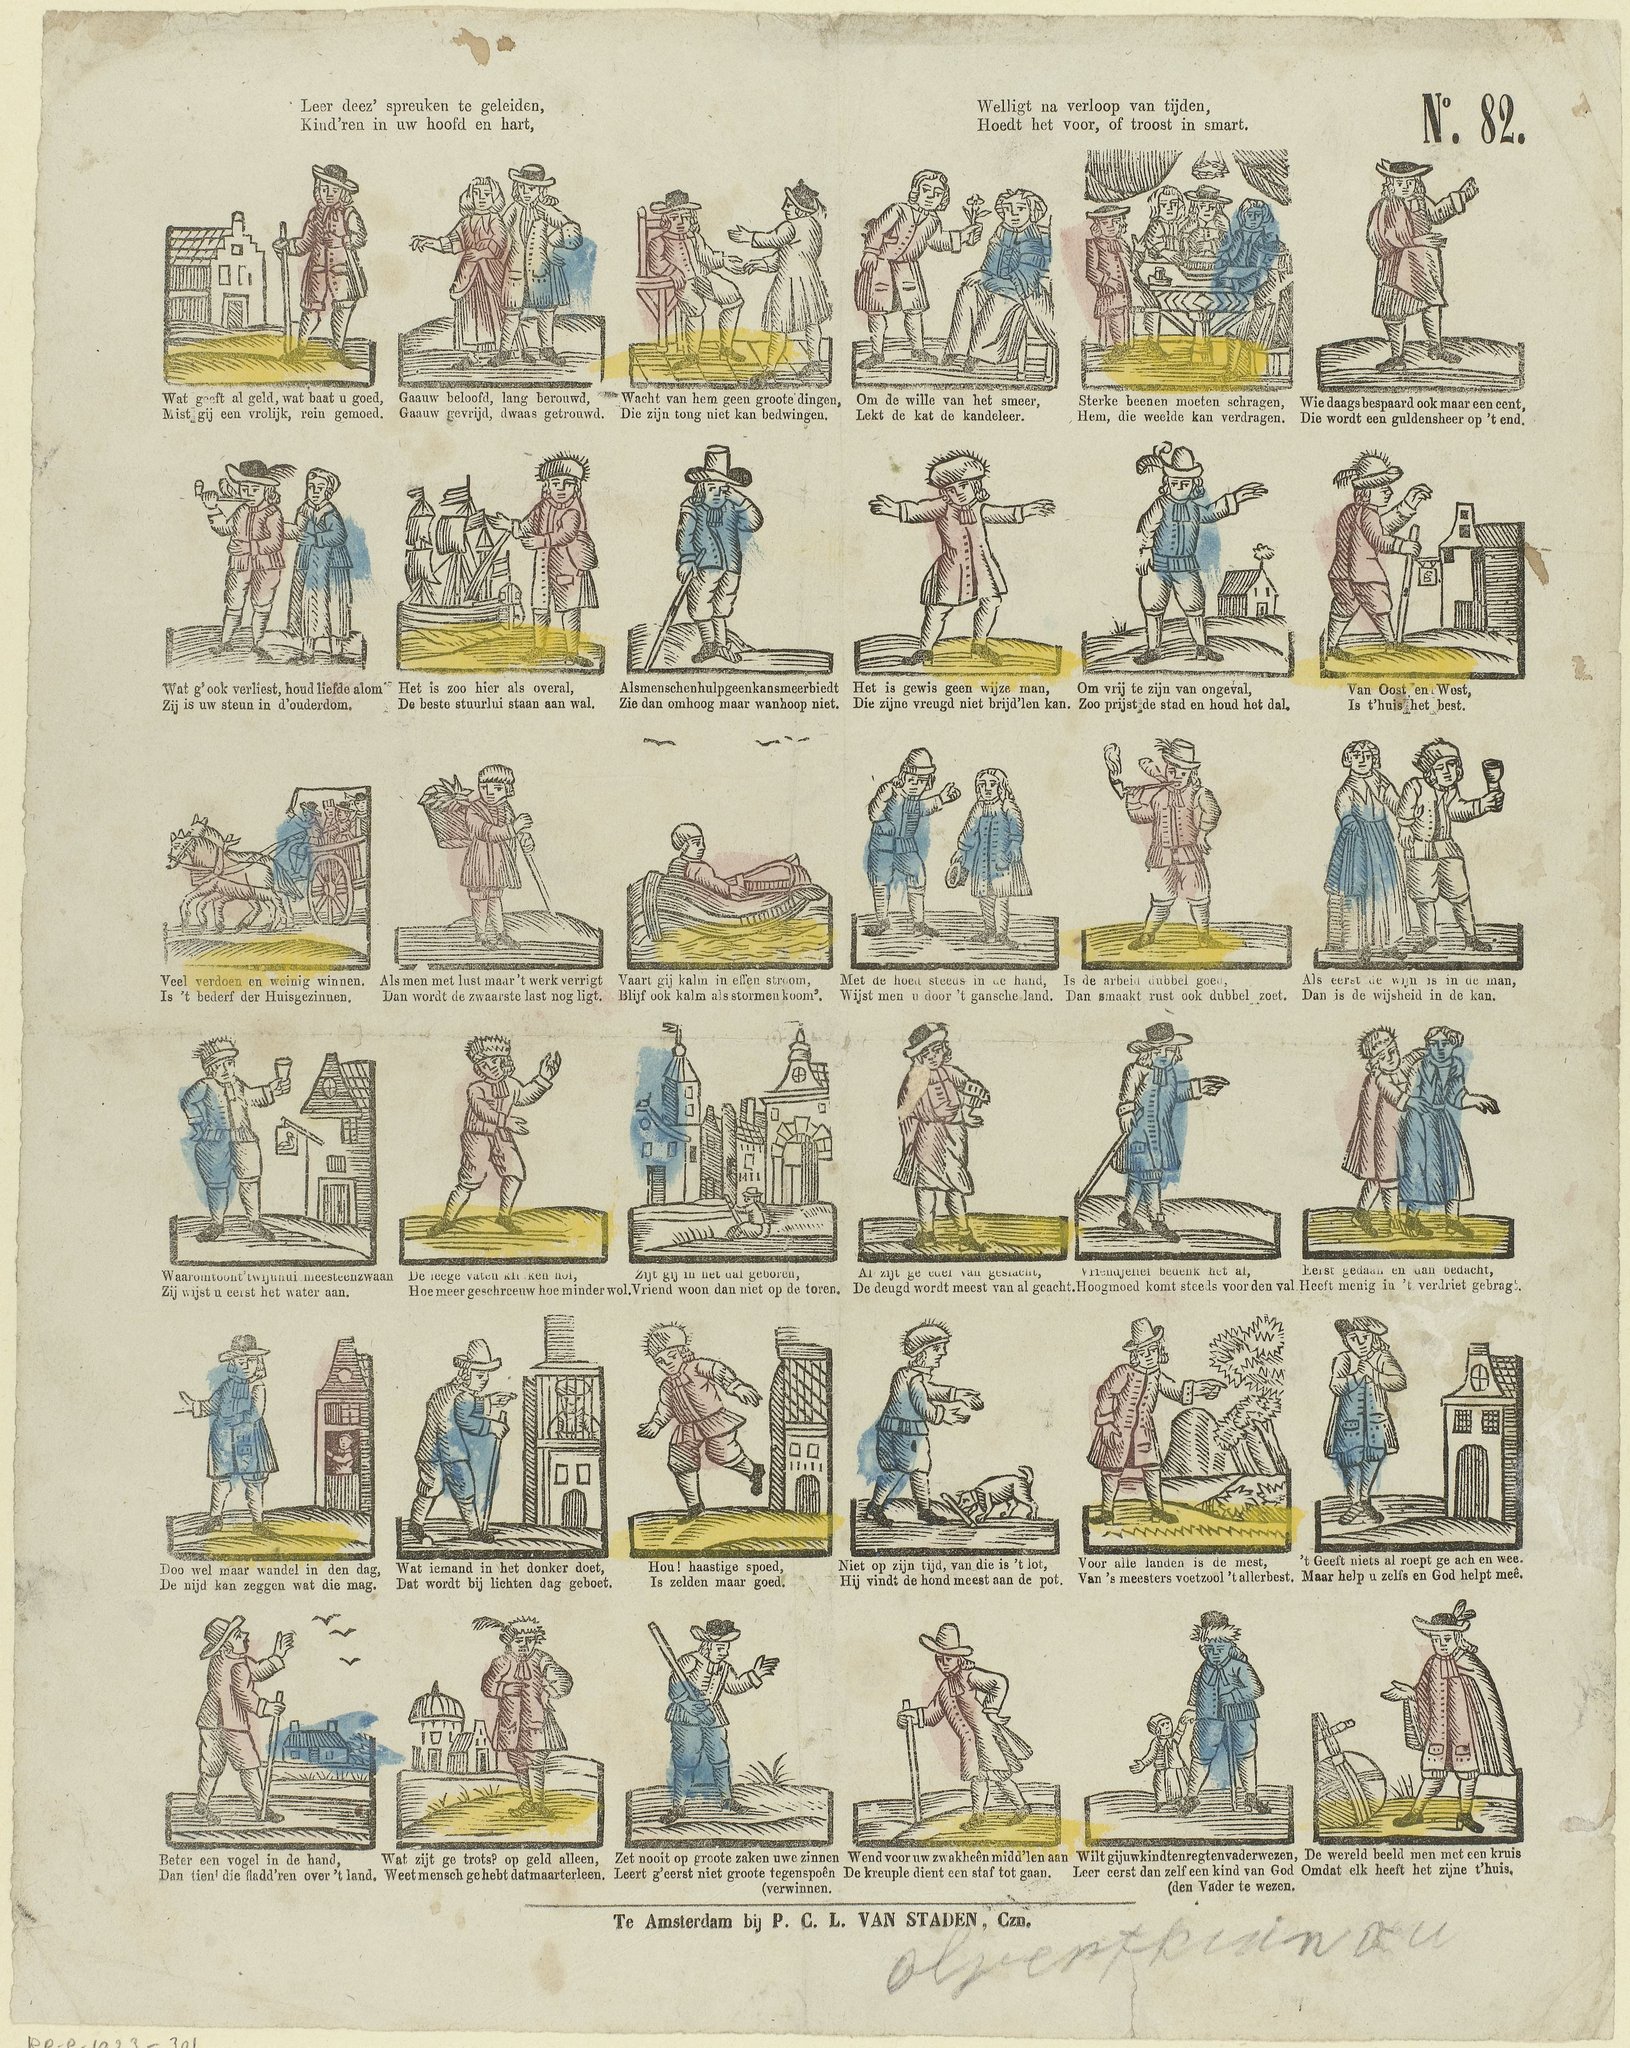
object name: popular print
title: Leer deez' spreuken te geleiden, / Kind'ren in uw hoofd en hart, / Welligt na verloop van tijden, / Hoedt het voor, of troost in smart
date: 1850-1870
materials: paper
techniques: colour, letterpress printing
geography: amsterdam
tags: proverbs, sayings, etc.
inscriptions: collector's mark: Lugt 2760, inscription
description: Blad met 36 verbeeldingen van spreekwoorden en wijze raad. Onder elke afbeelding een tweeregelig onderschrift. Genummerd rechtsboven: No. 82.